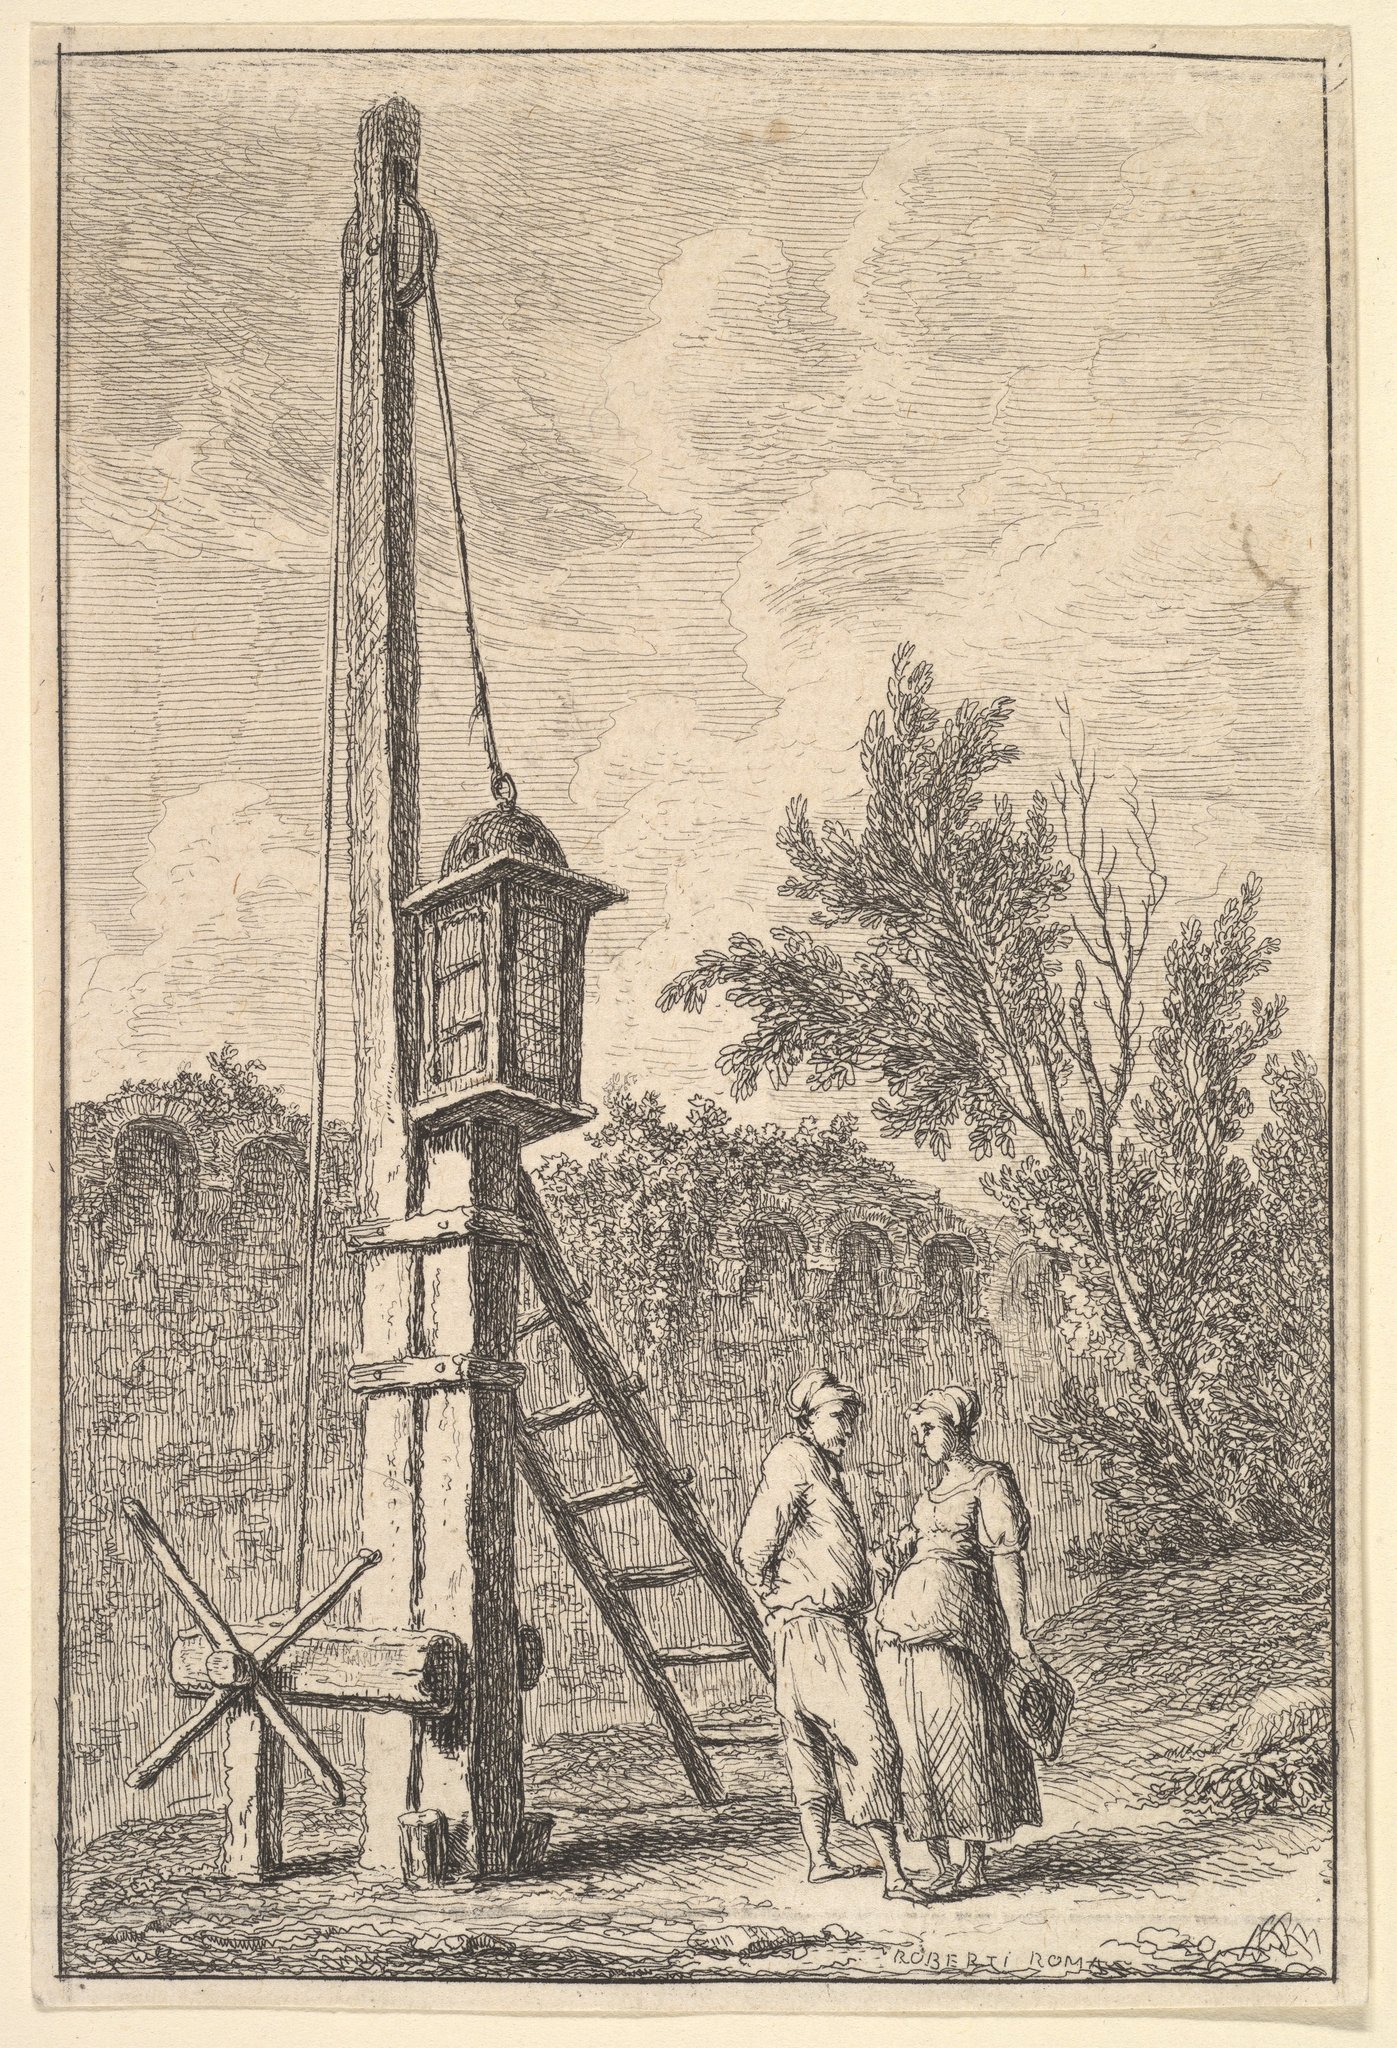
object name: print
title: Plate 9: The Pulley: a man and a woman conversing to right, a lantern hung on a post to left, from "Les soirées de Rome"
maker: hubert robert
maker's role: artist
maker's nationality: french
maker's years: 1733-1808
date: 1763-1764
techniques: etching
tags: men,women,ladders,lanterns